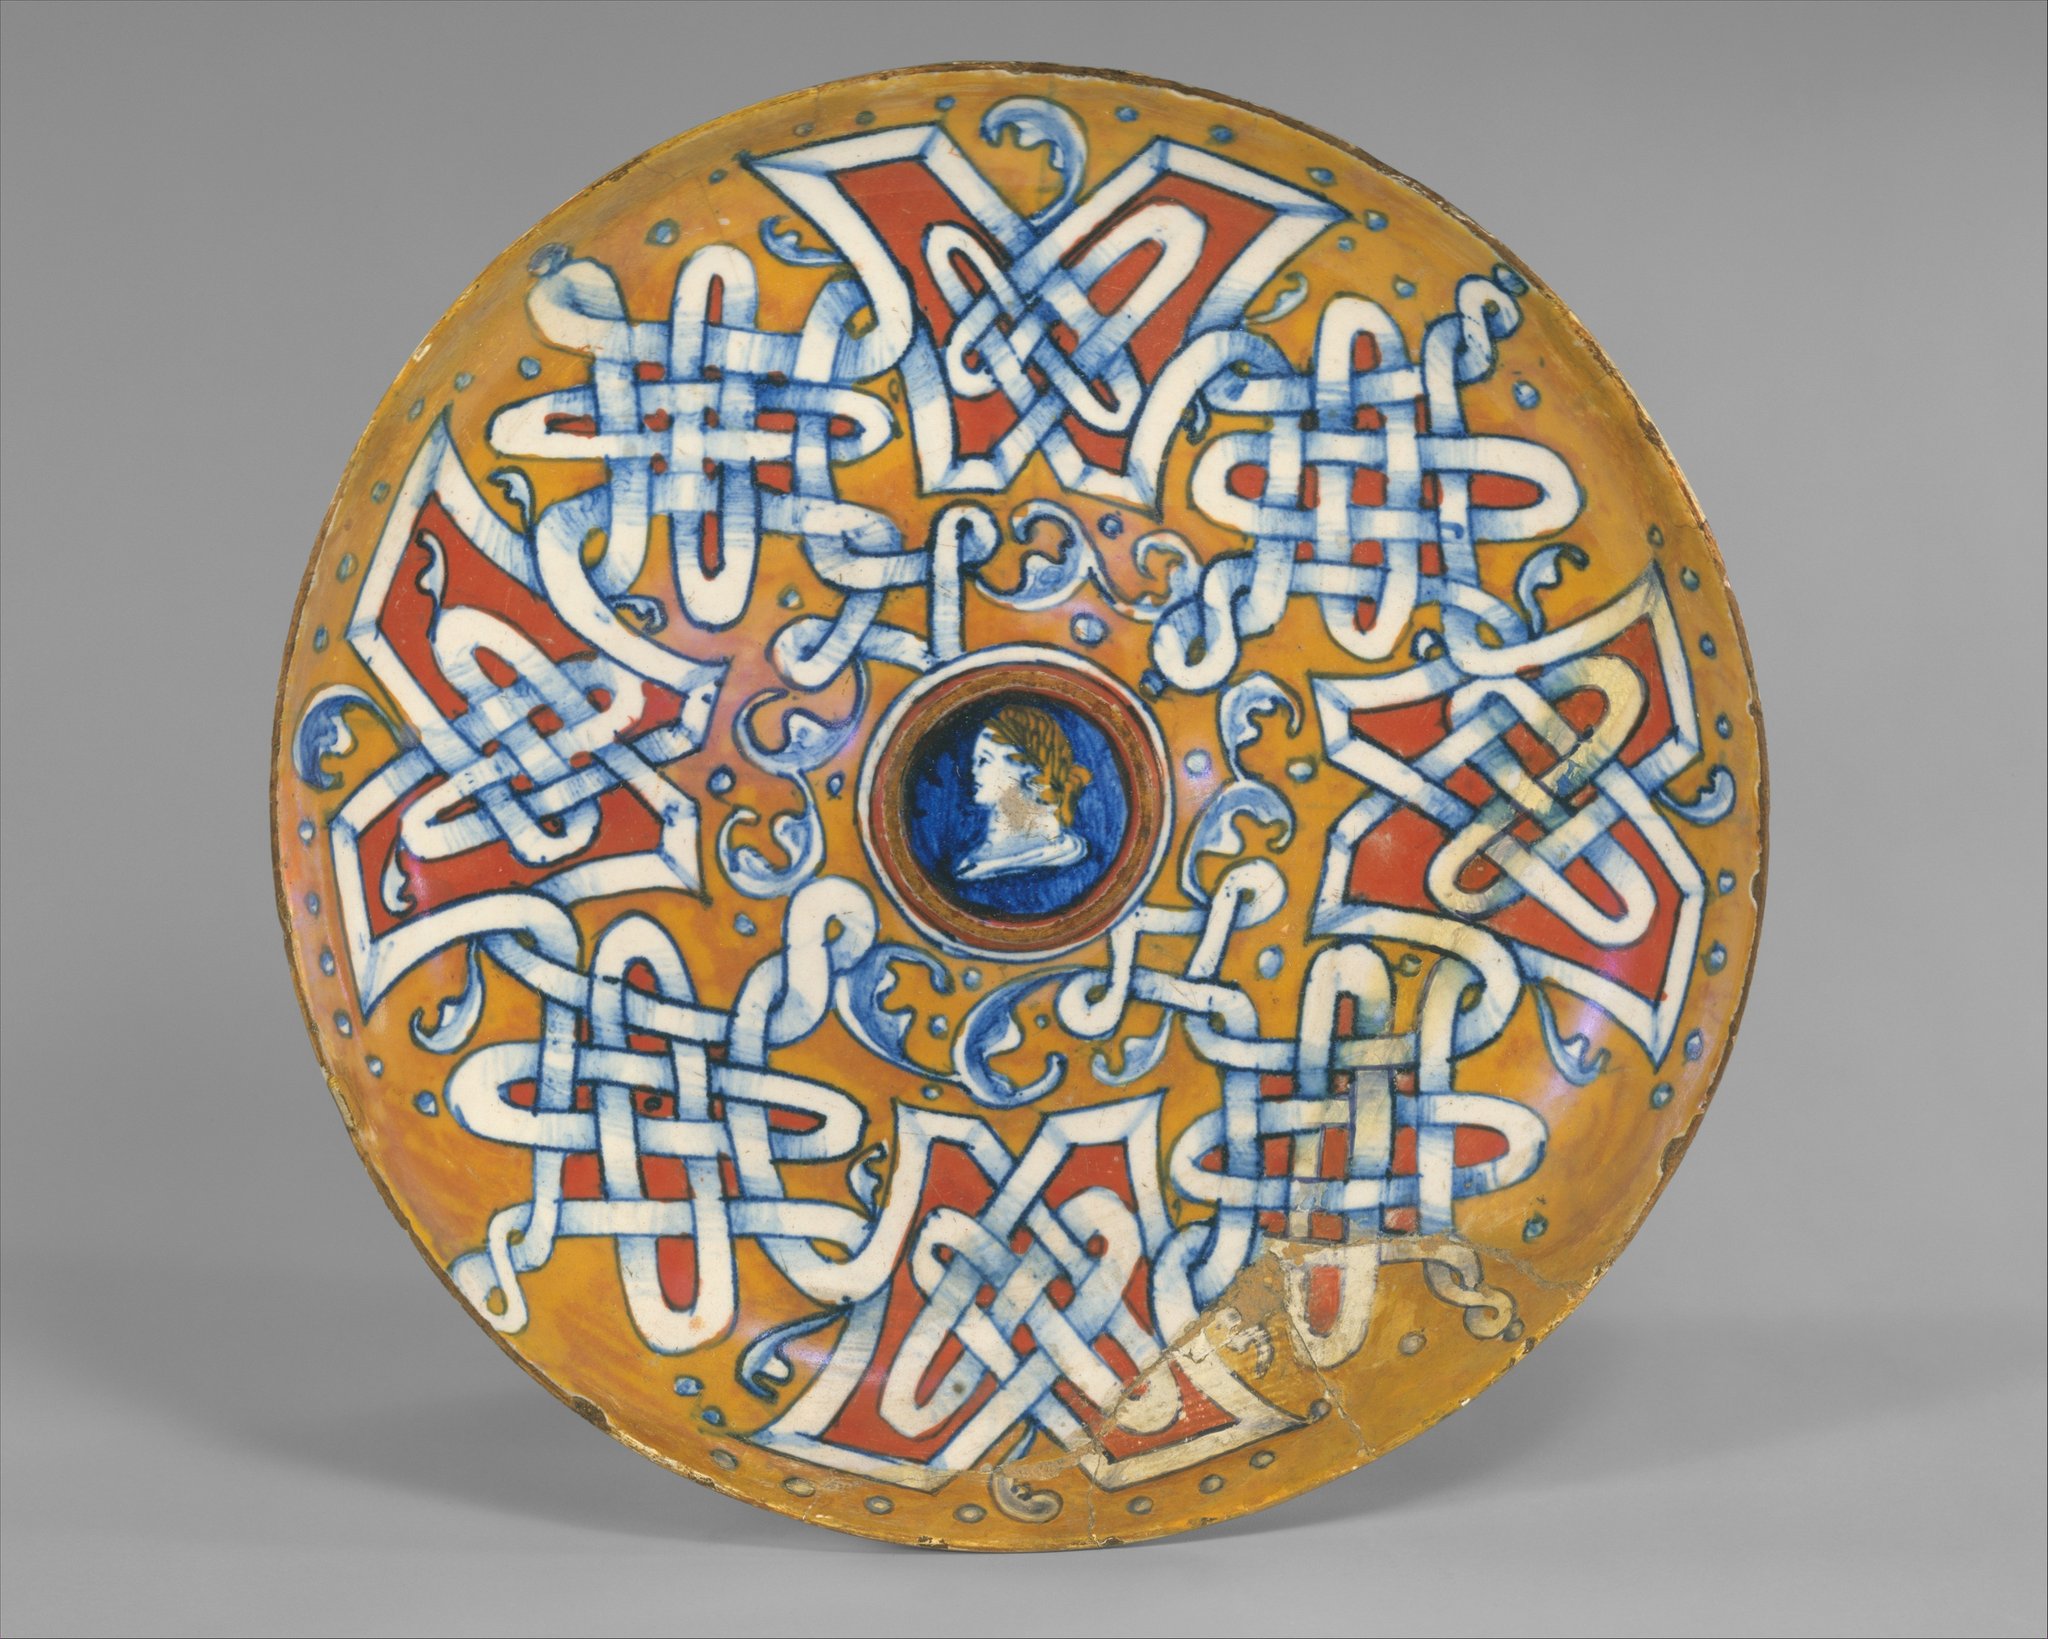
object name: dish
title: Dish (coppa umbonata)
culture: italian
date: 1530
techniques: maiolica, glazing